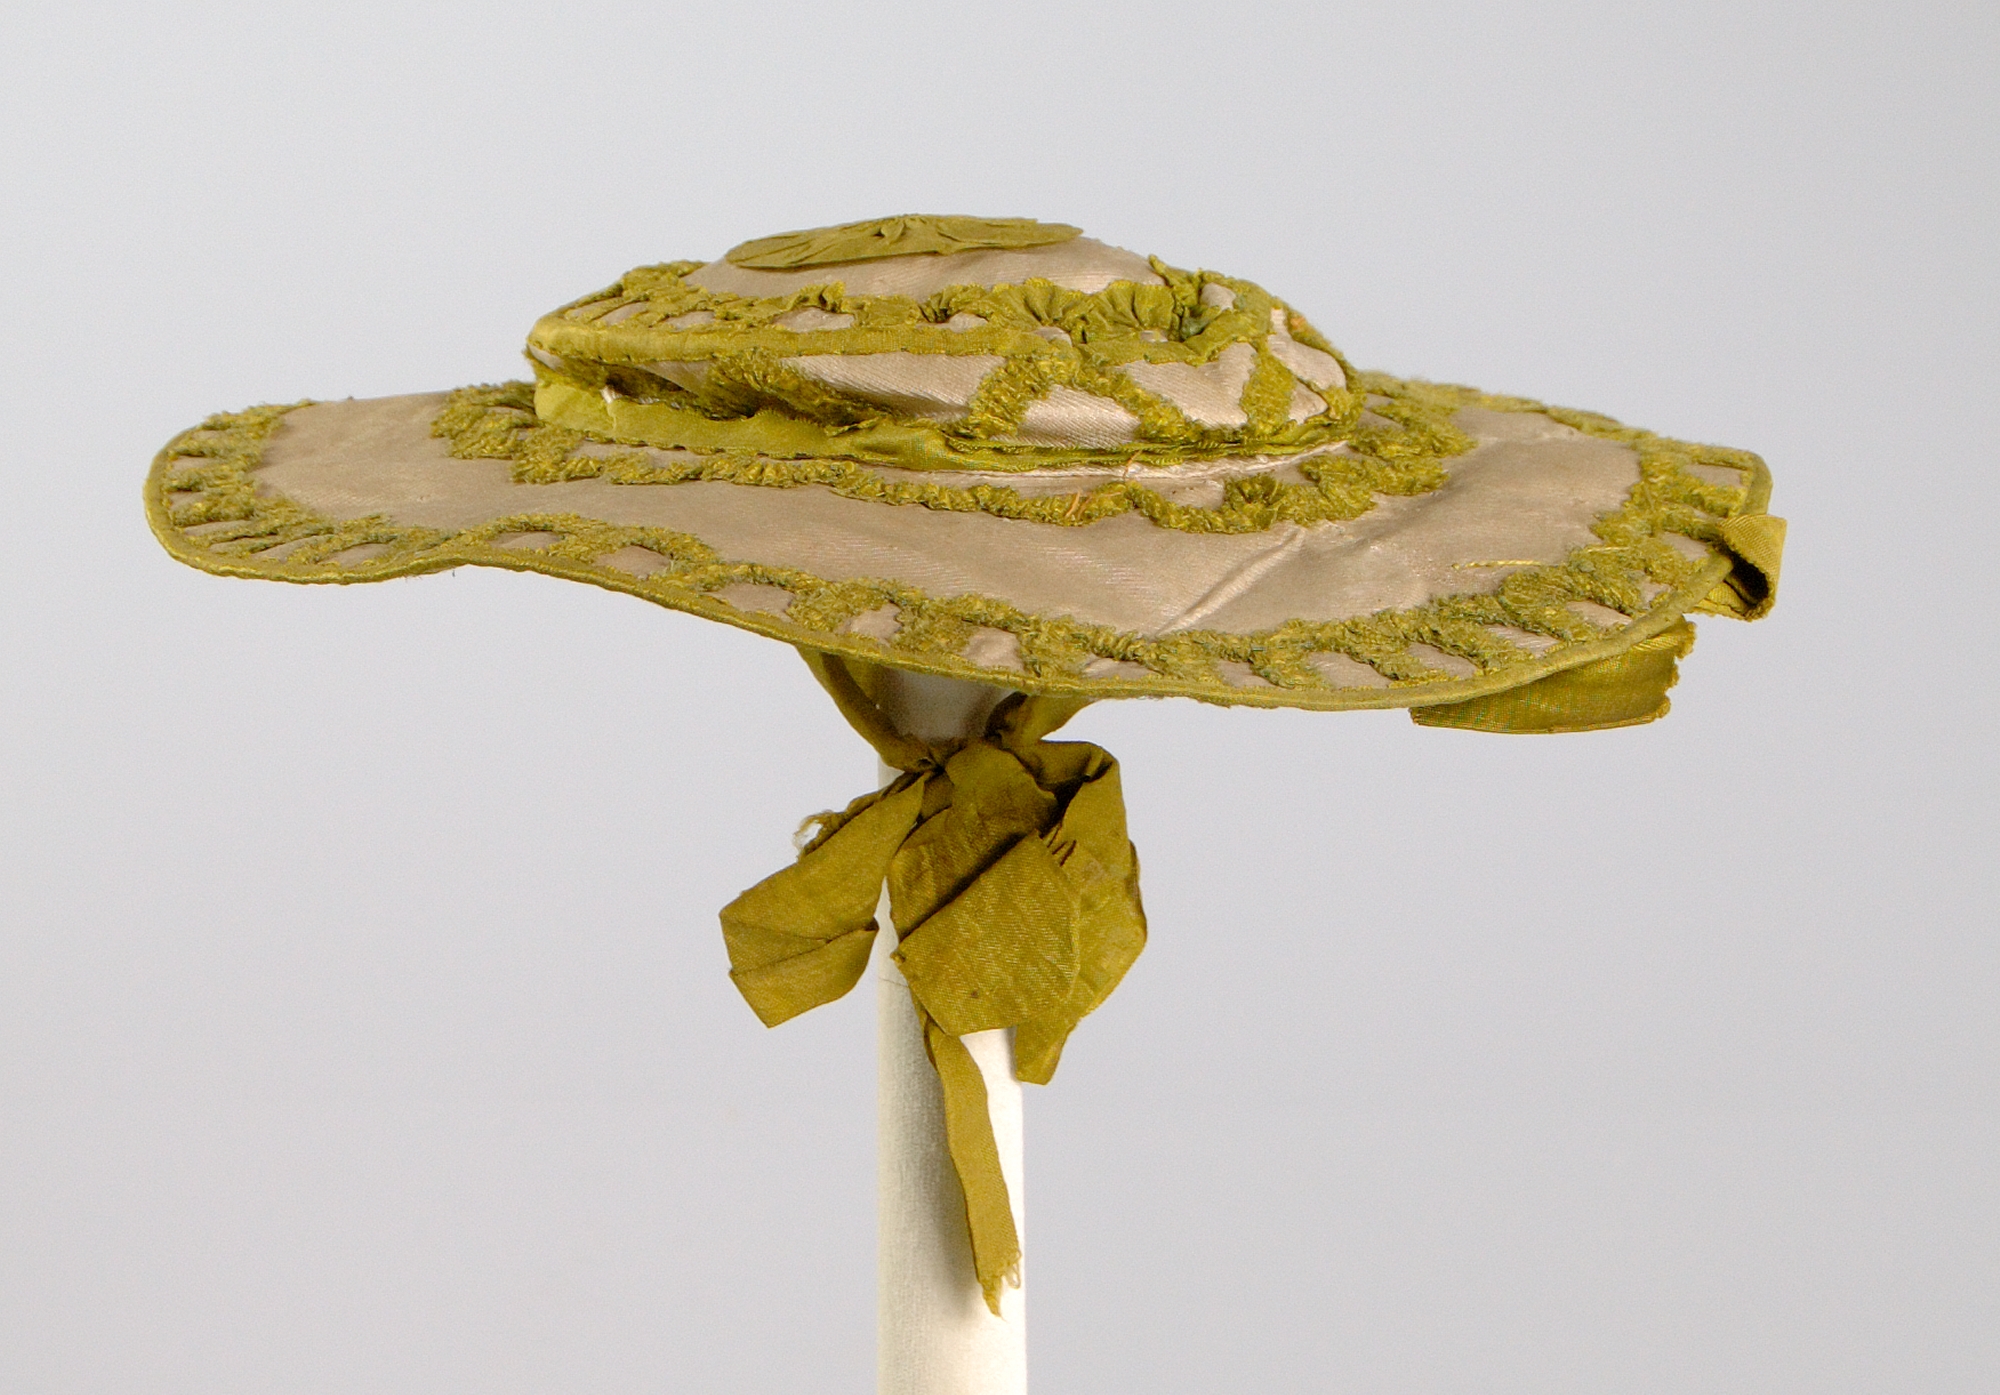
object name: hat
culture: european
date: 1780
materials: cotton, linen, silk